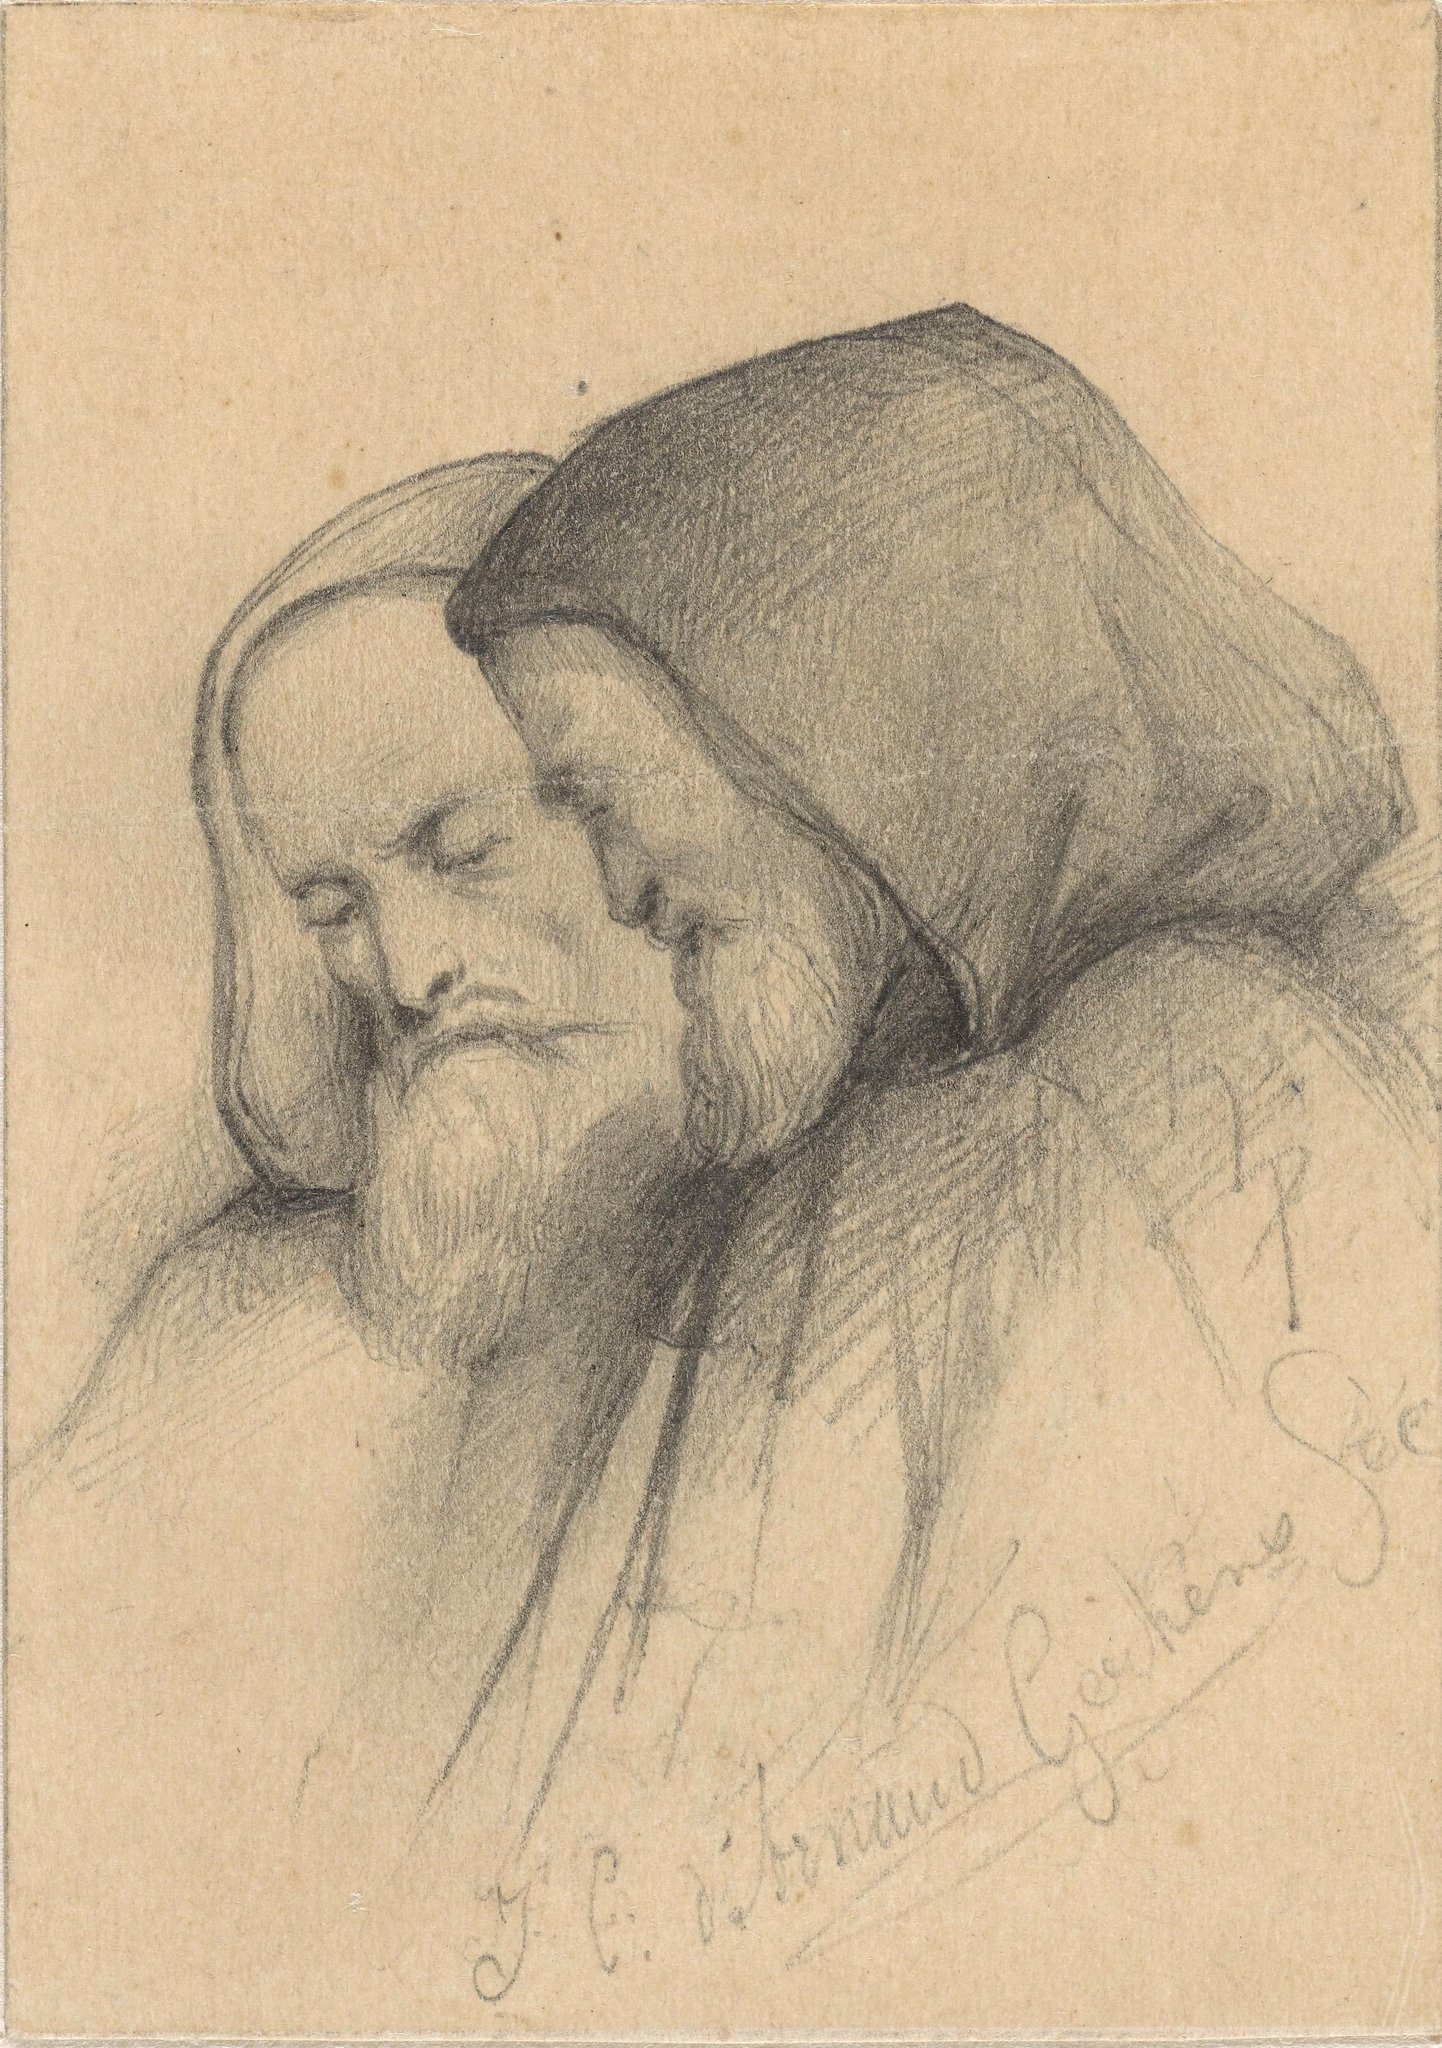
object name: drawing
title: Twee grijsaards in monniksdracht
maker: johannes christiaan d arnaud gerkens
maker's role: draughtsman, print maker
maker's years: 1823-1892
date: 1833-1892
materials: paper, pencil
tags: monk(s), friar(s)